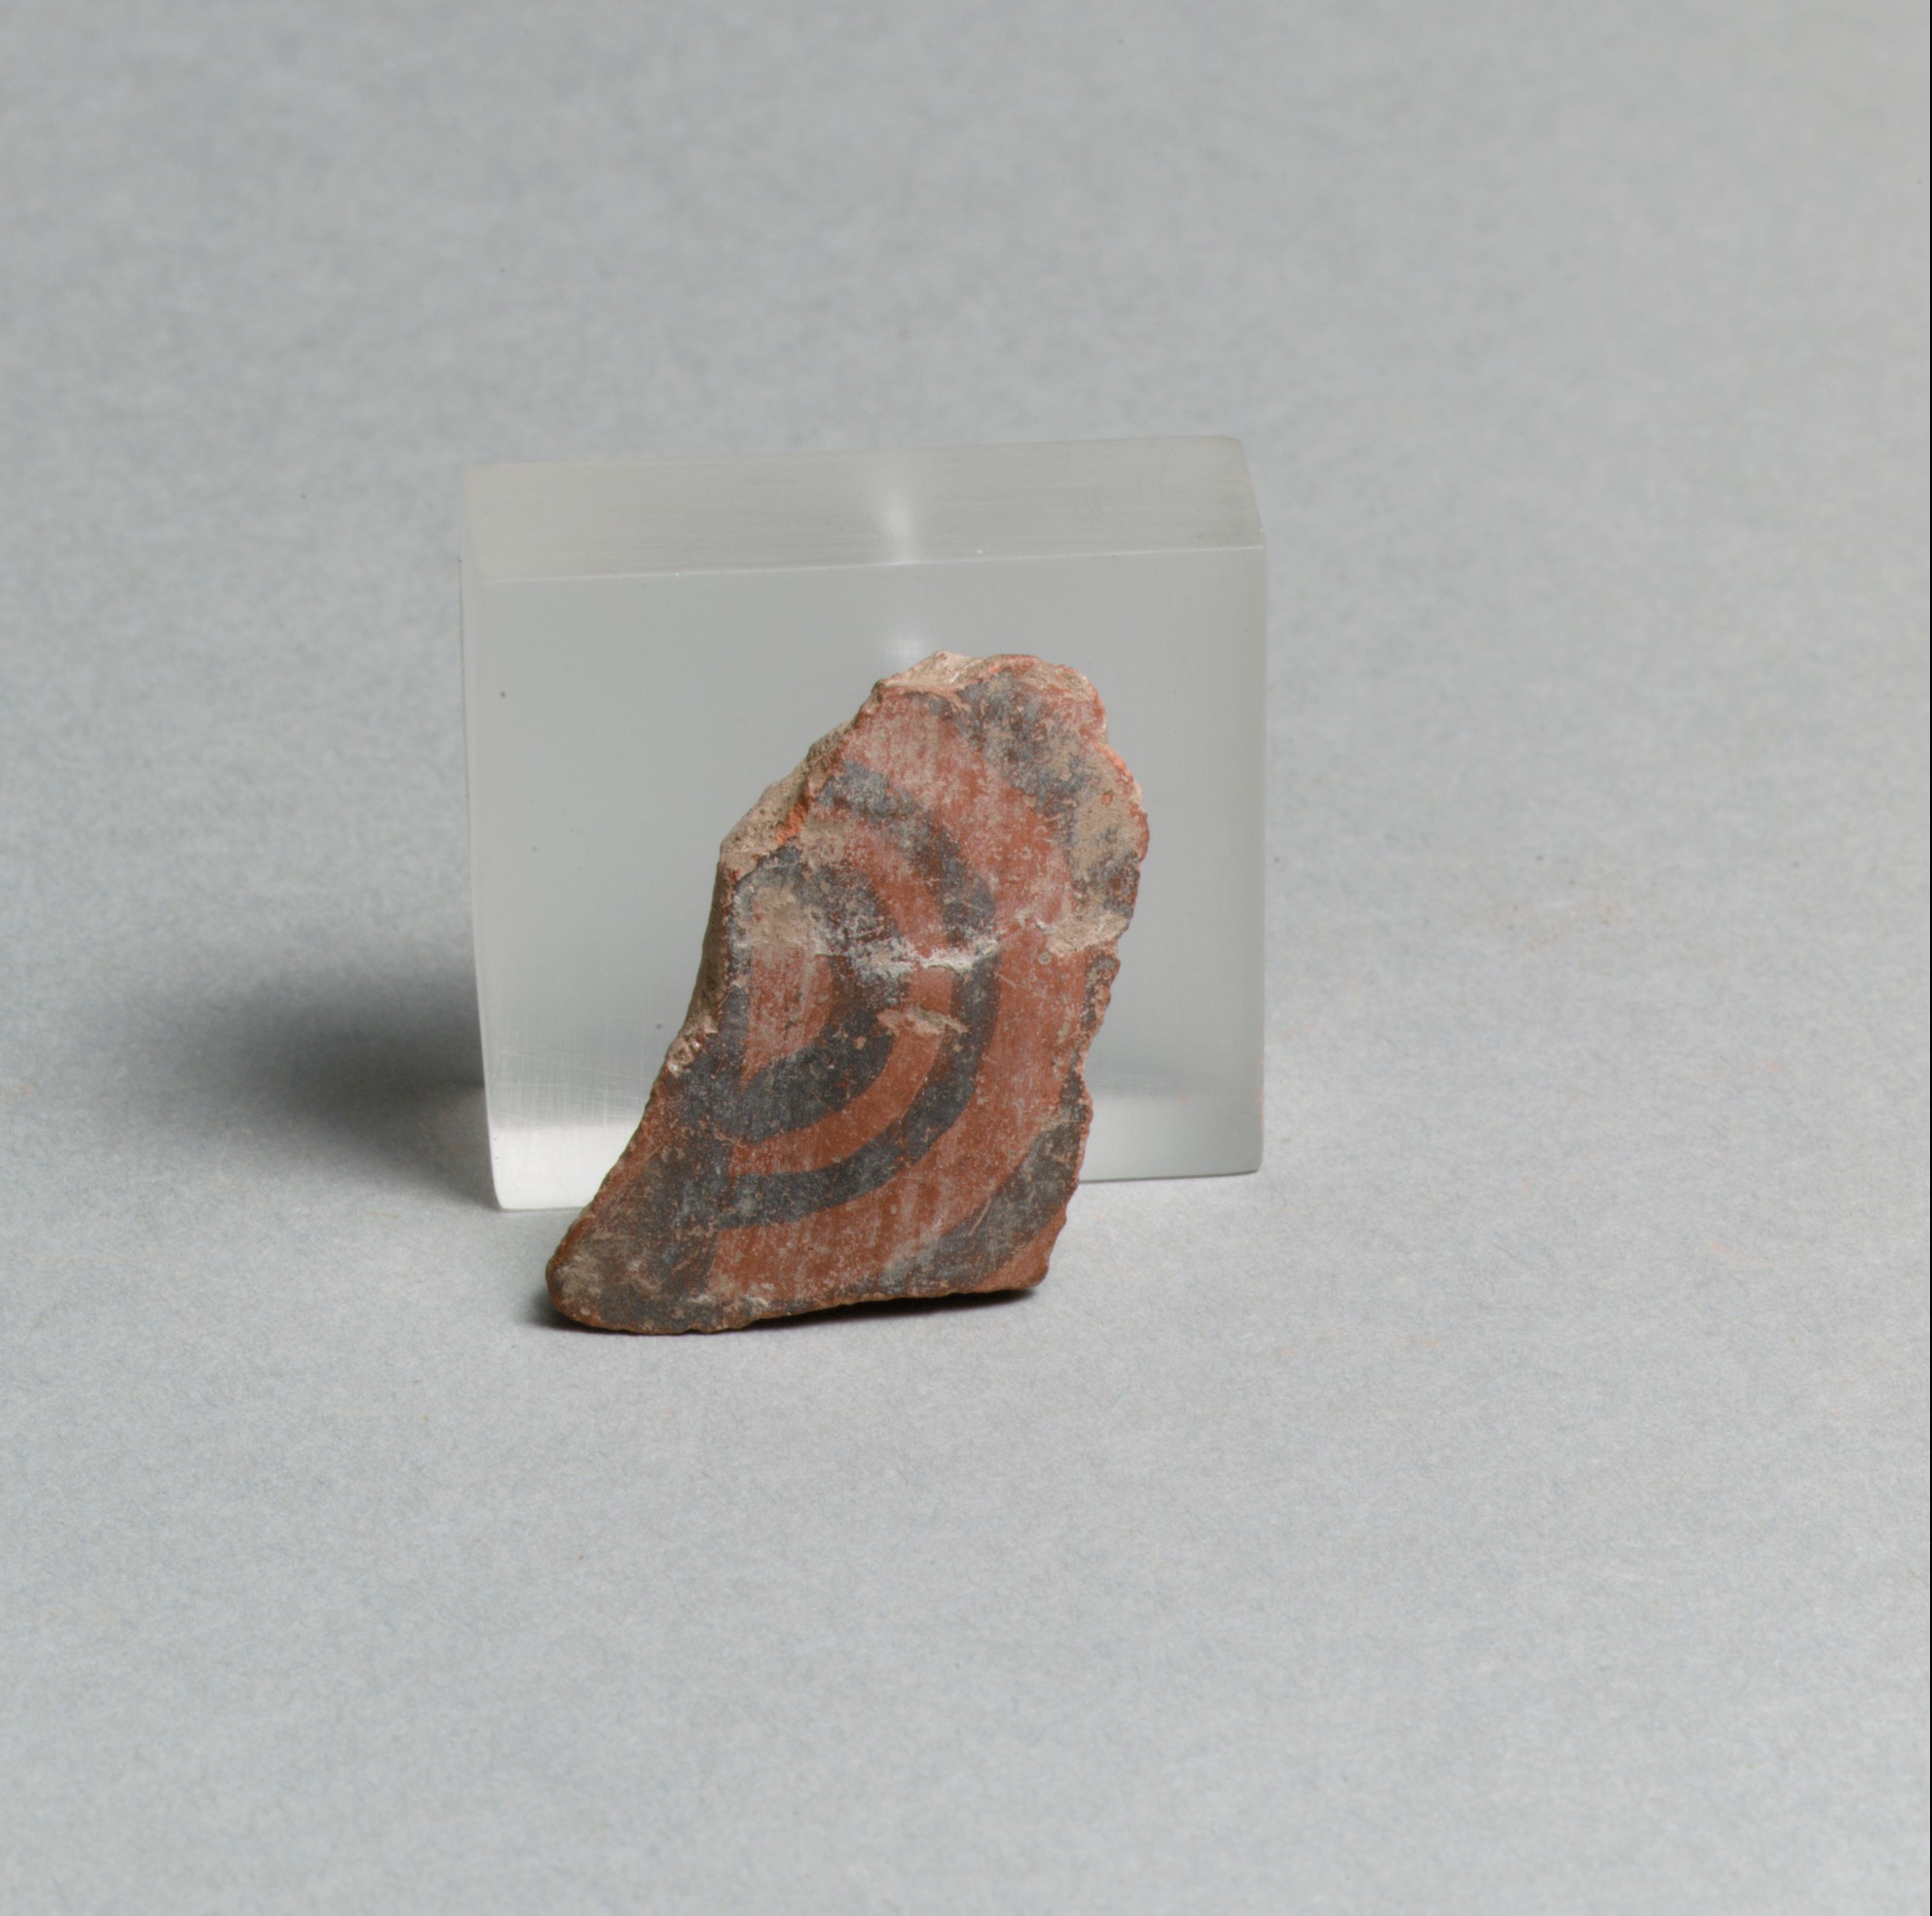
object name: vase fragment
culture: greek or lydian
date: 1050-700 BCE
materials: terracotta